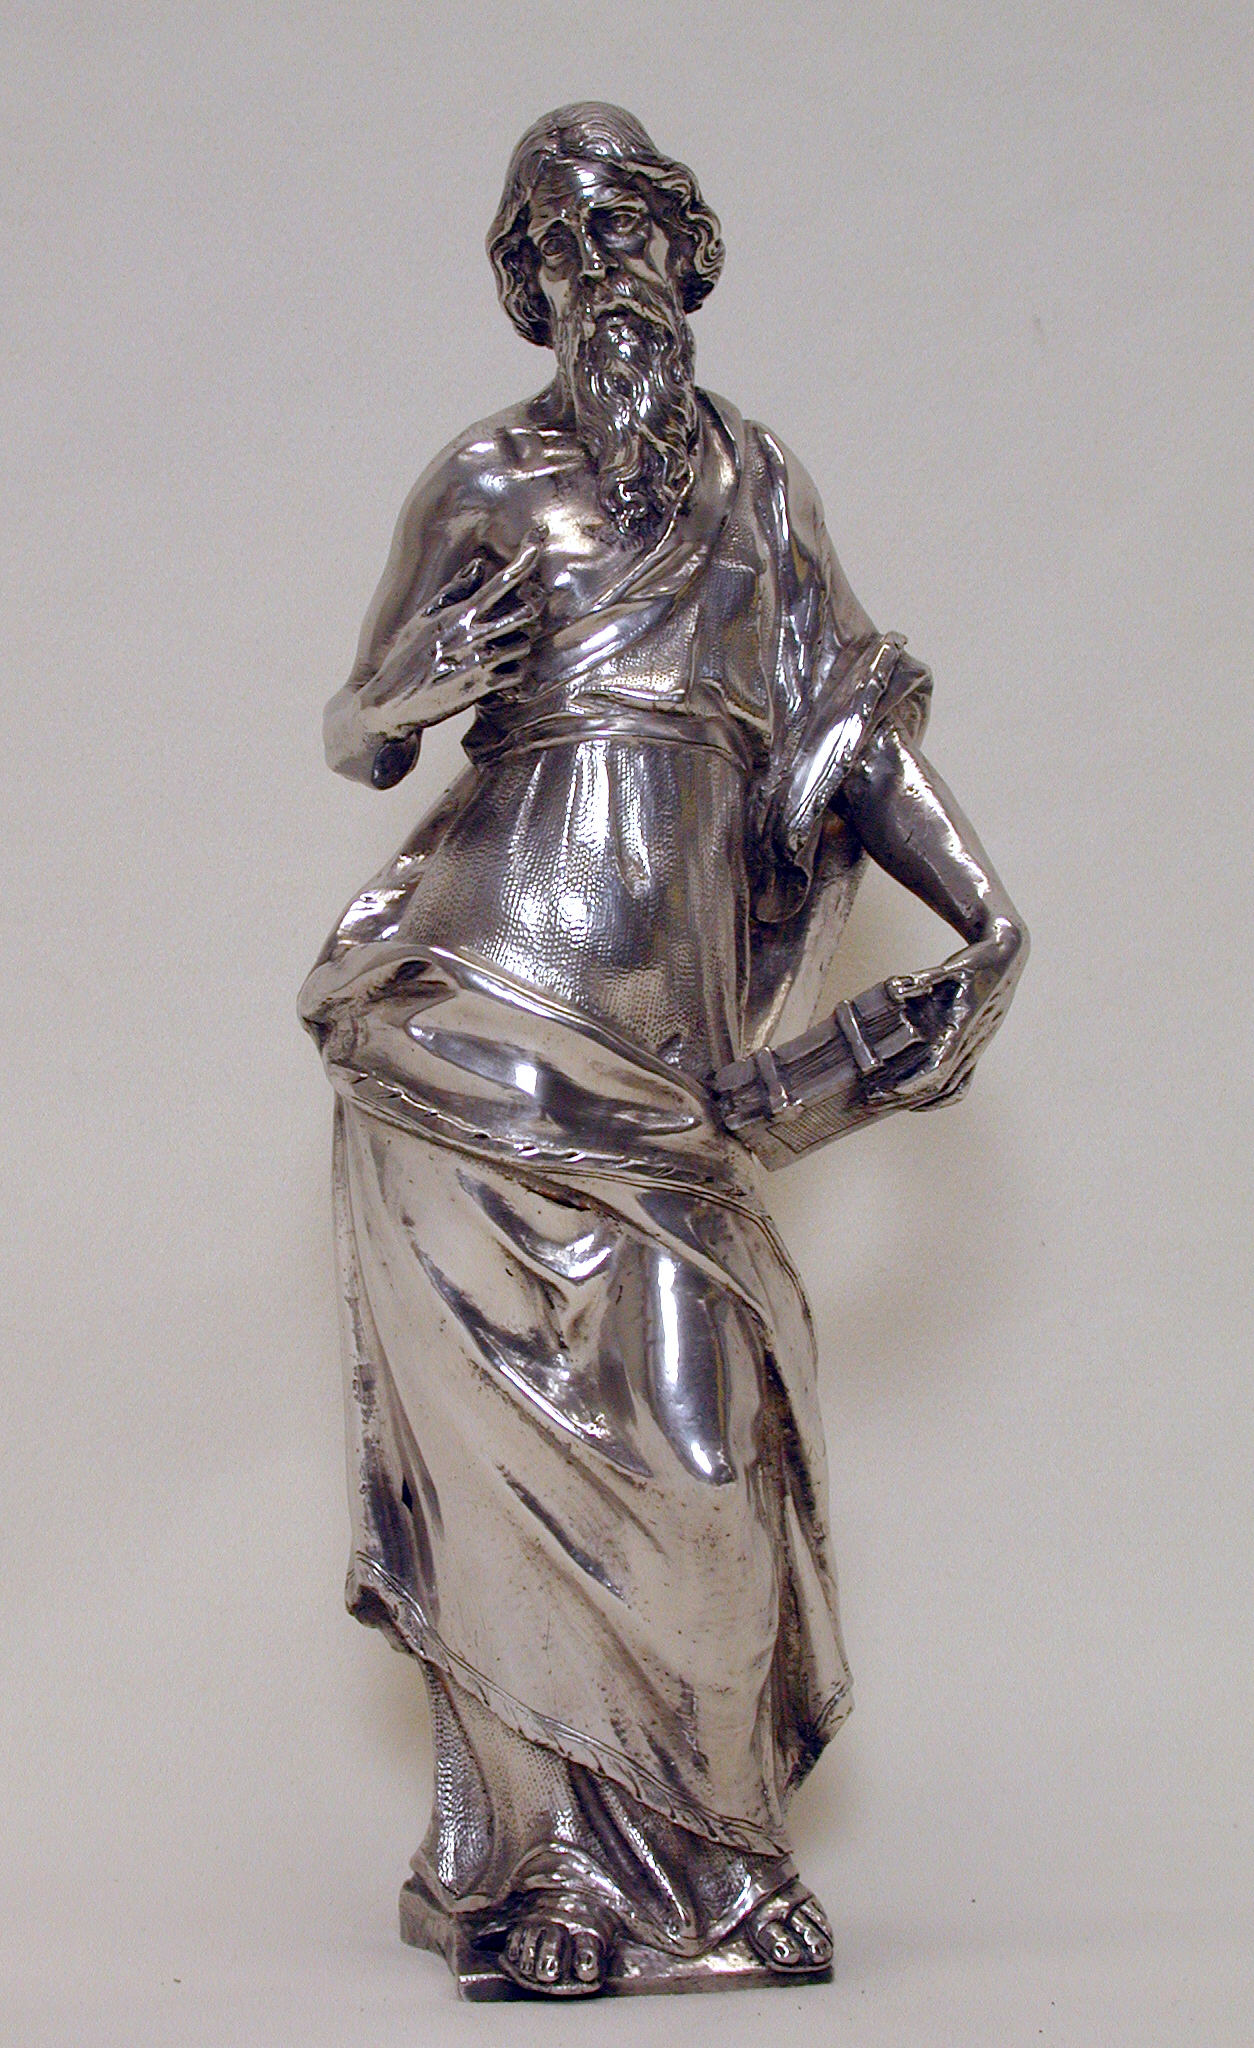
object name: statuette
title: Figure of a Saint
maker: francesco mochi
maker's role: artist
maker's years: 1580-1654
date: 1630-1640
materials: silver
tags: saints